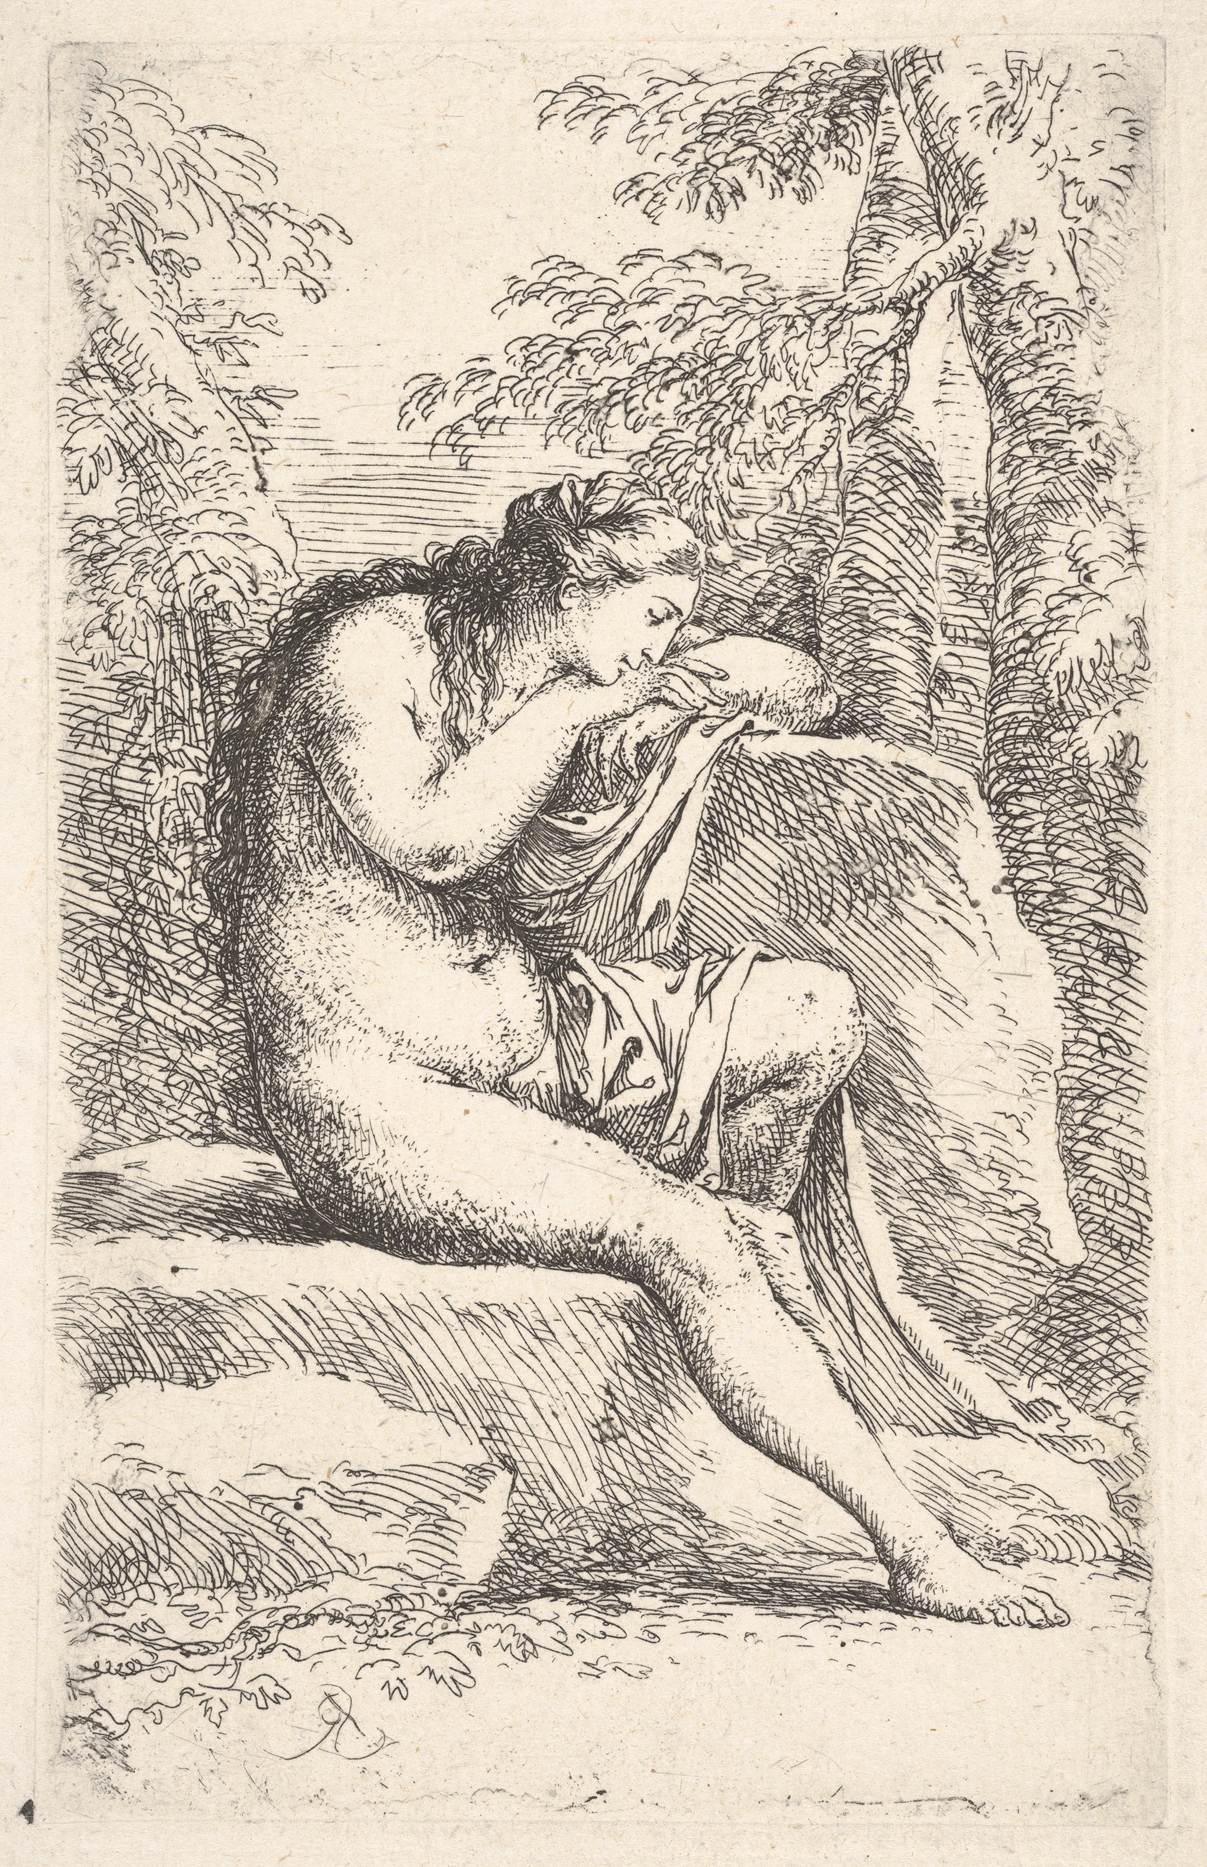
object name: print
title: A semi-nude woman seated, resting her head on a rock, from "Figurine"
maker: salvator rosa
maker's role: artist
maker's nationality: italian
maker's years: 1615-1673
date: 1656-1657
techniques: drypoint, etching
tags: female nudes